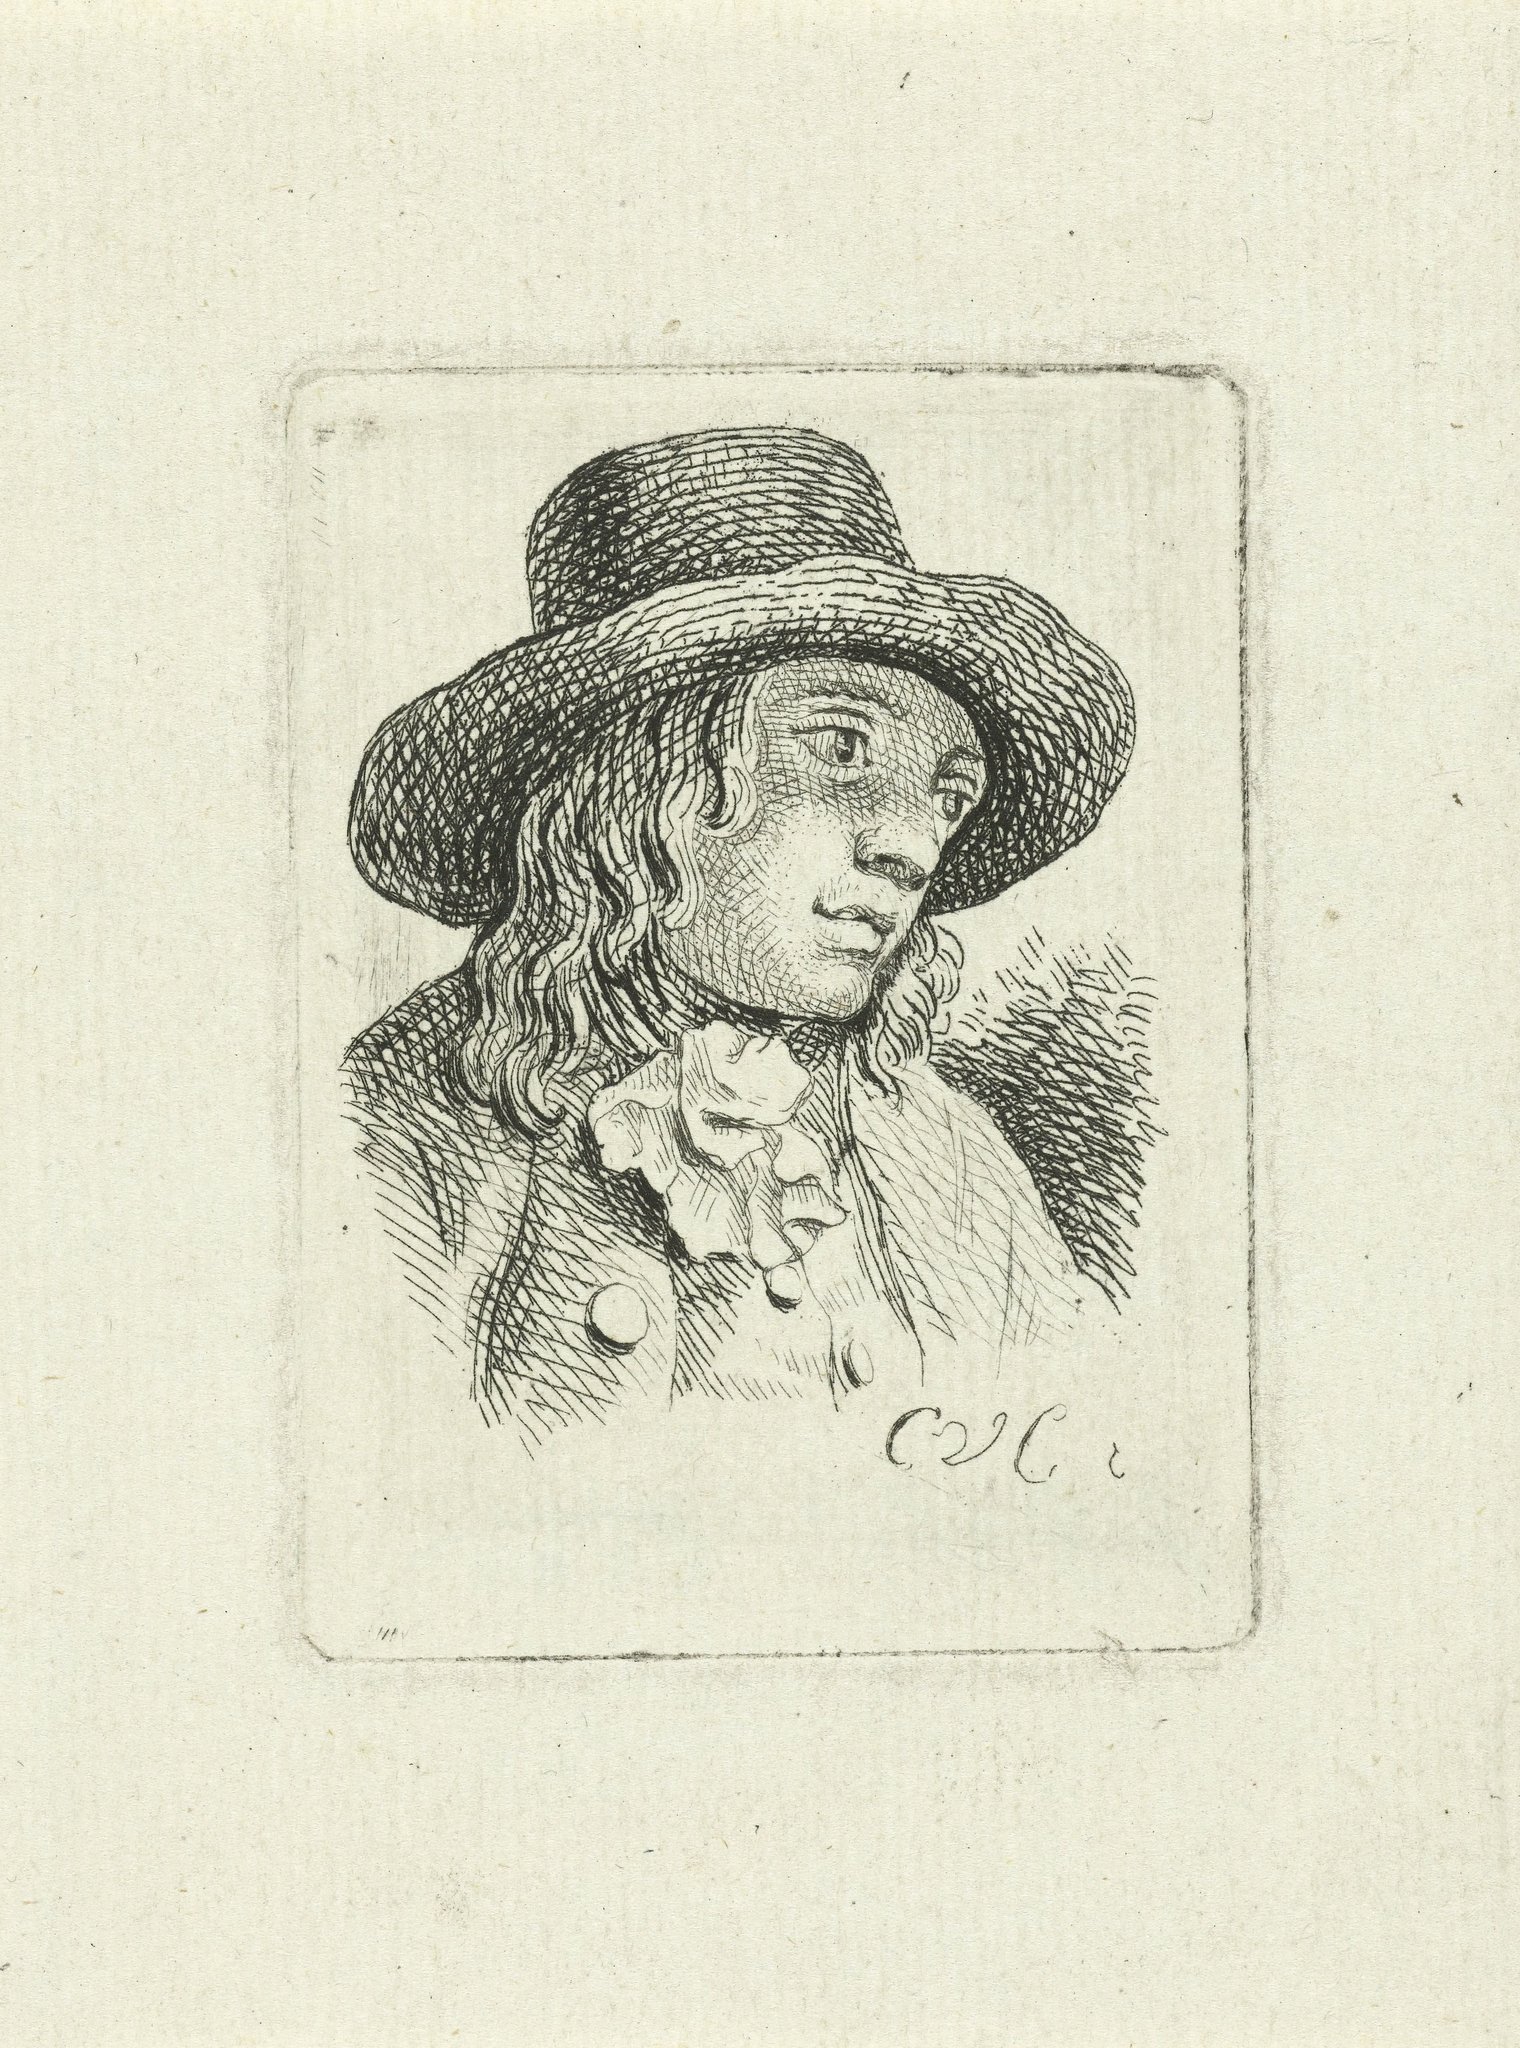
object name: print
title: Jonge man met hoed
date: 1768-1827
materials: paper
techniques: etching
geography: netherlands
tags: youth, adolescent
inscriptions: collector's mark: Lugt 2228